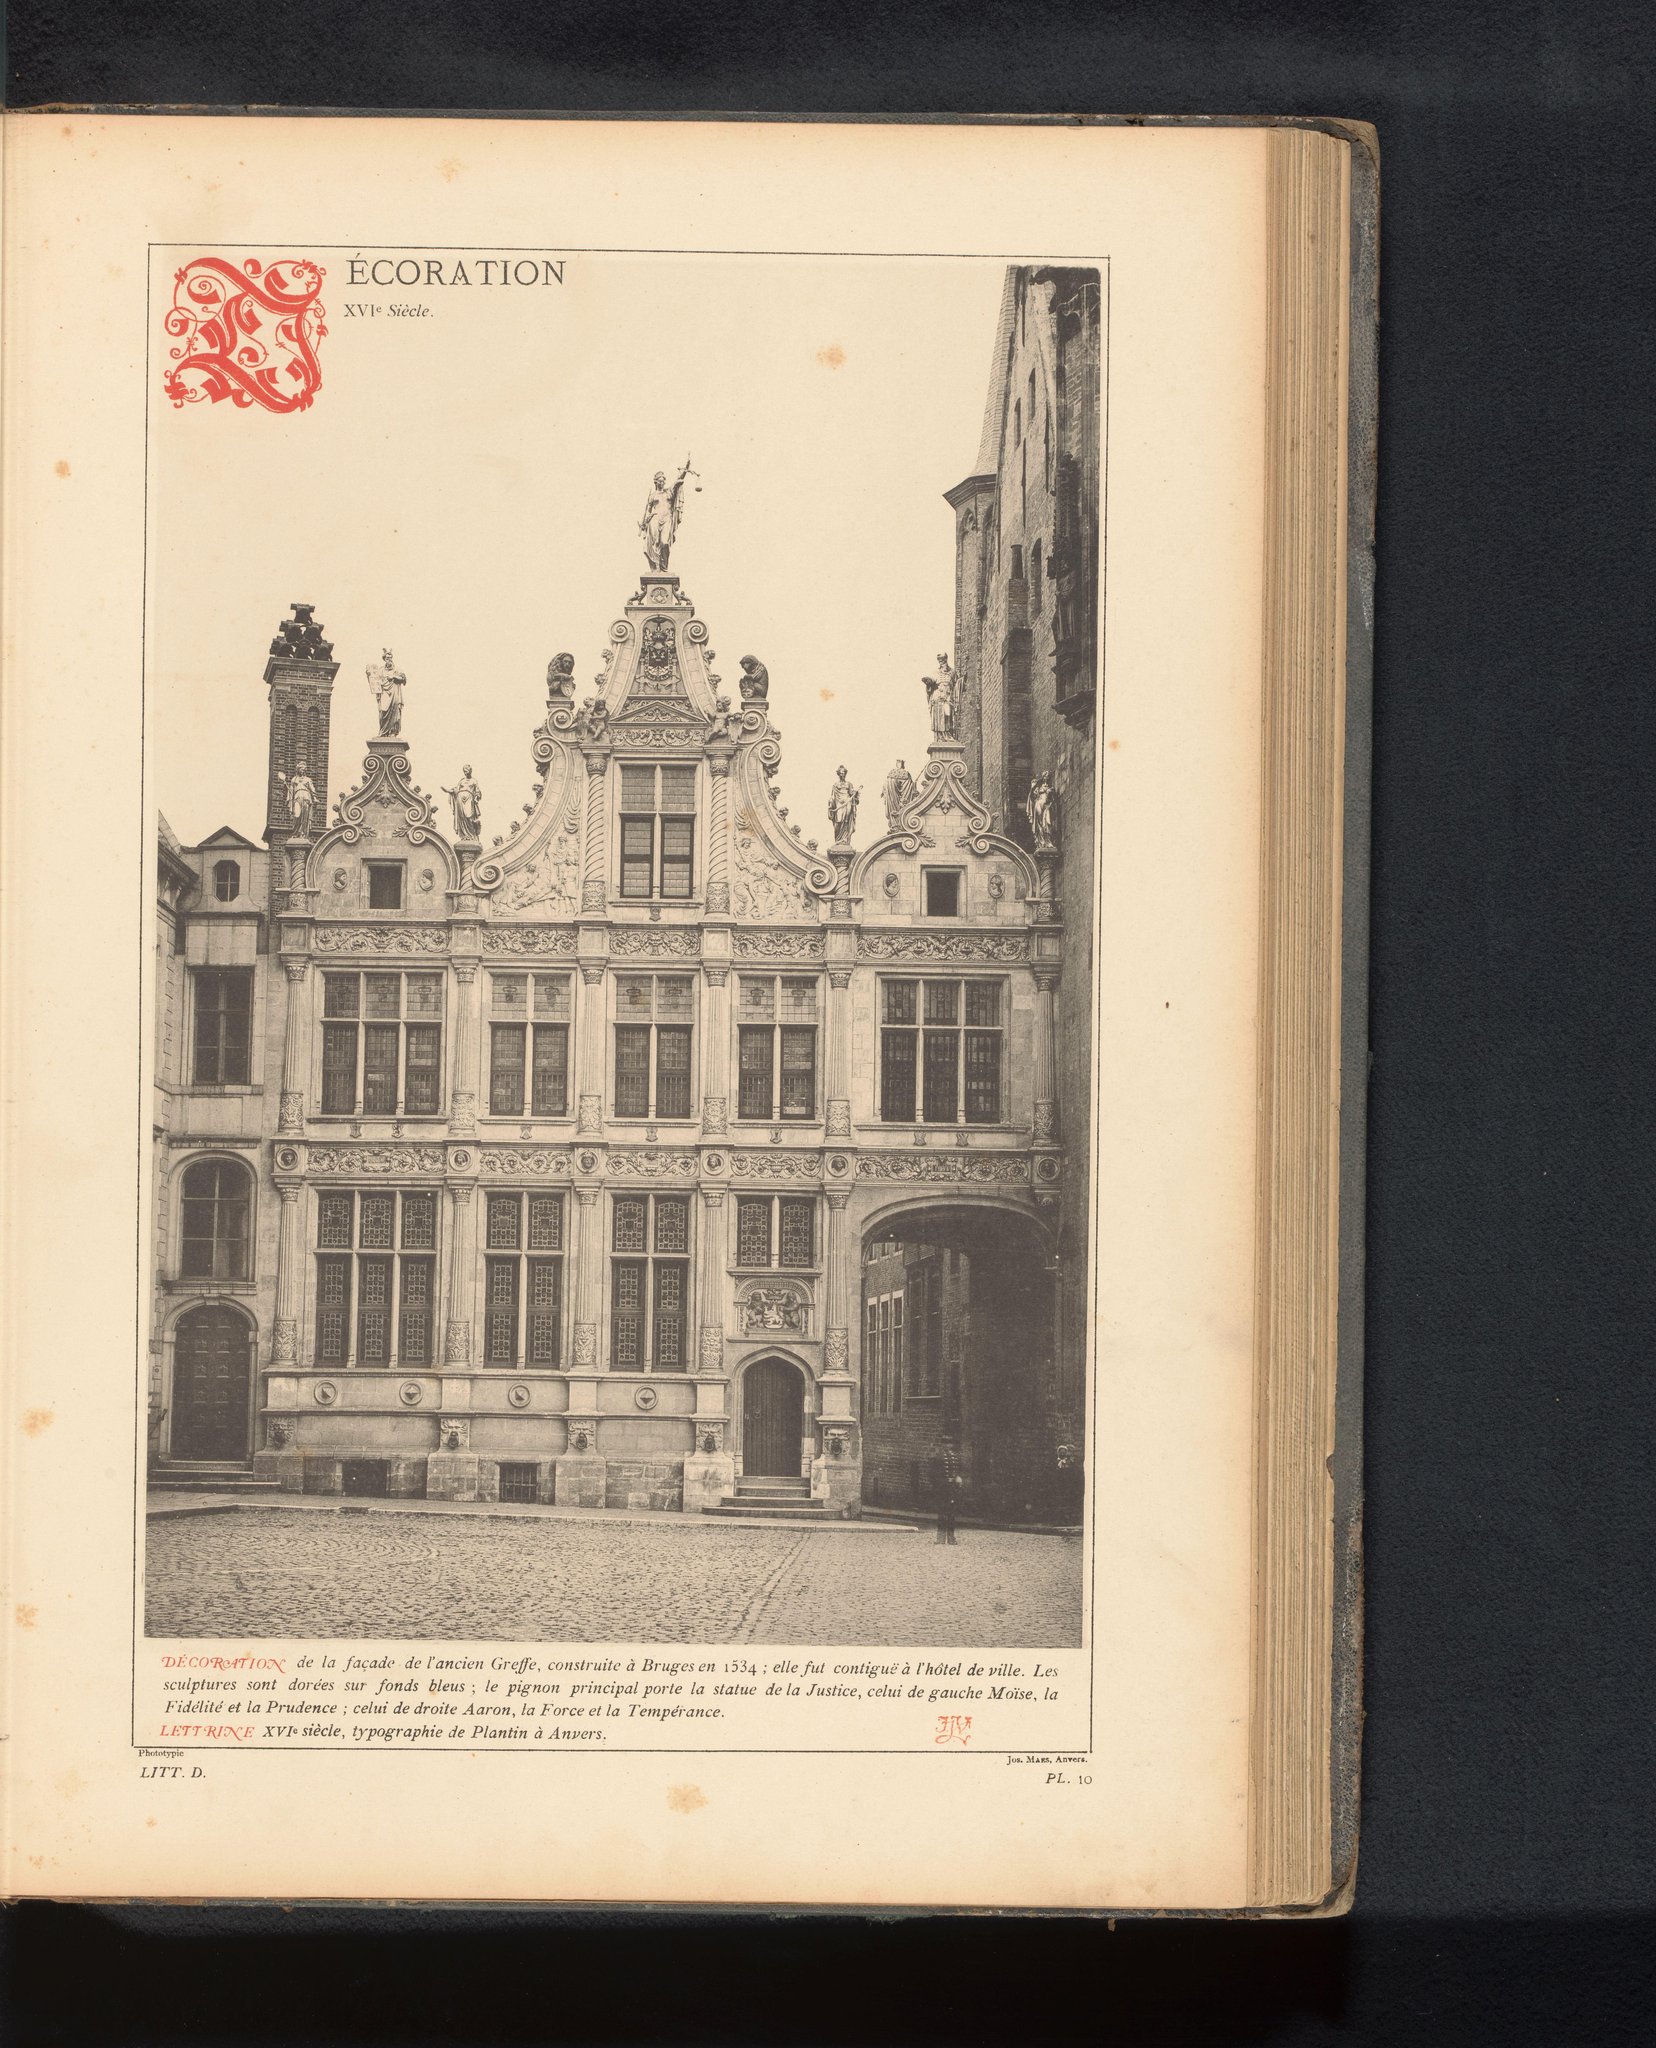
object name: page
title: Gezicht op de voorzijde van de Vrije van Brugge, België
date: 1875-1880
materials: paper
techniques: photograph, photolithography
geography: antwerp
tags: front façade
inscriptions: inscription: ‘DÉCORATION de la (...)’, inscription: ‘LITT. D. - PL. 10’, monogram: ‘JJvY’